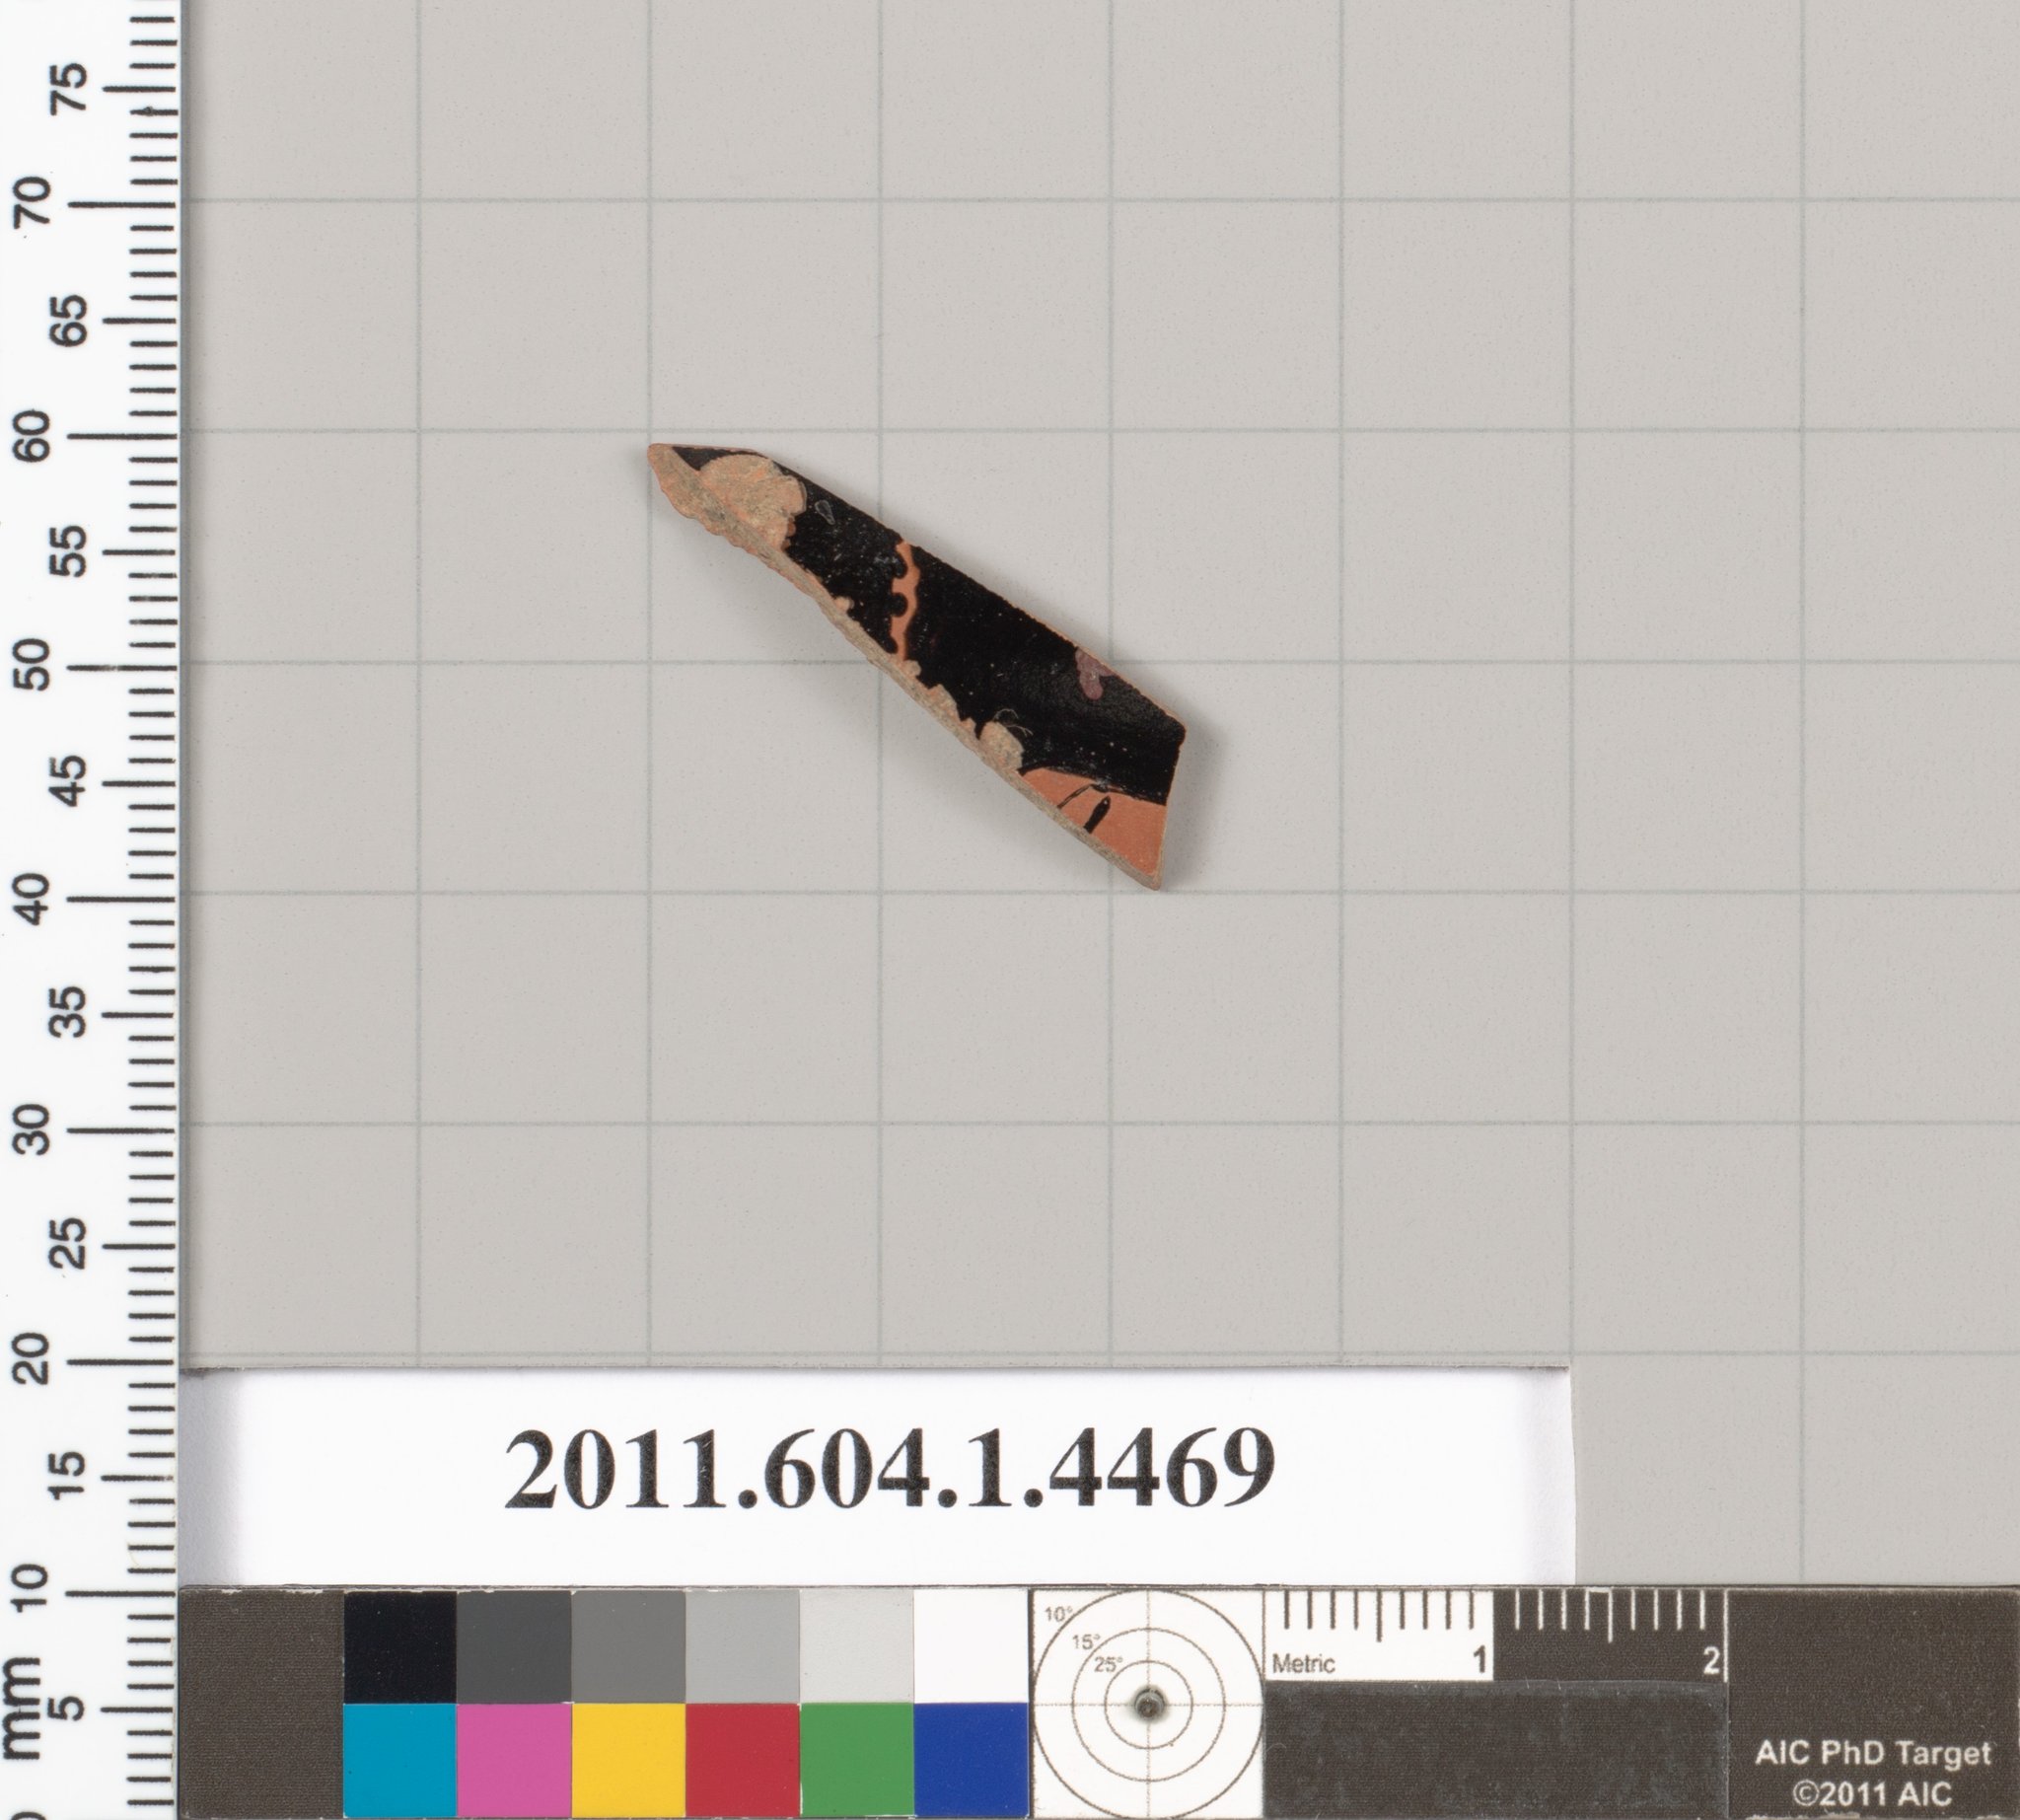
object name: kylix fragment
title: Terracotta rim fragment of a kylix (drinking cup)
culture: greek, attic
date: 500-480 BCE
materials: terracotta